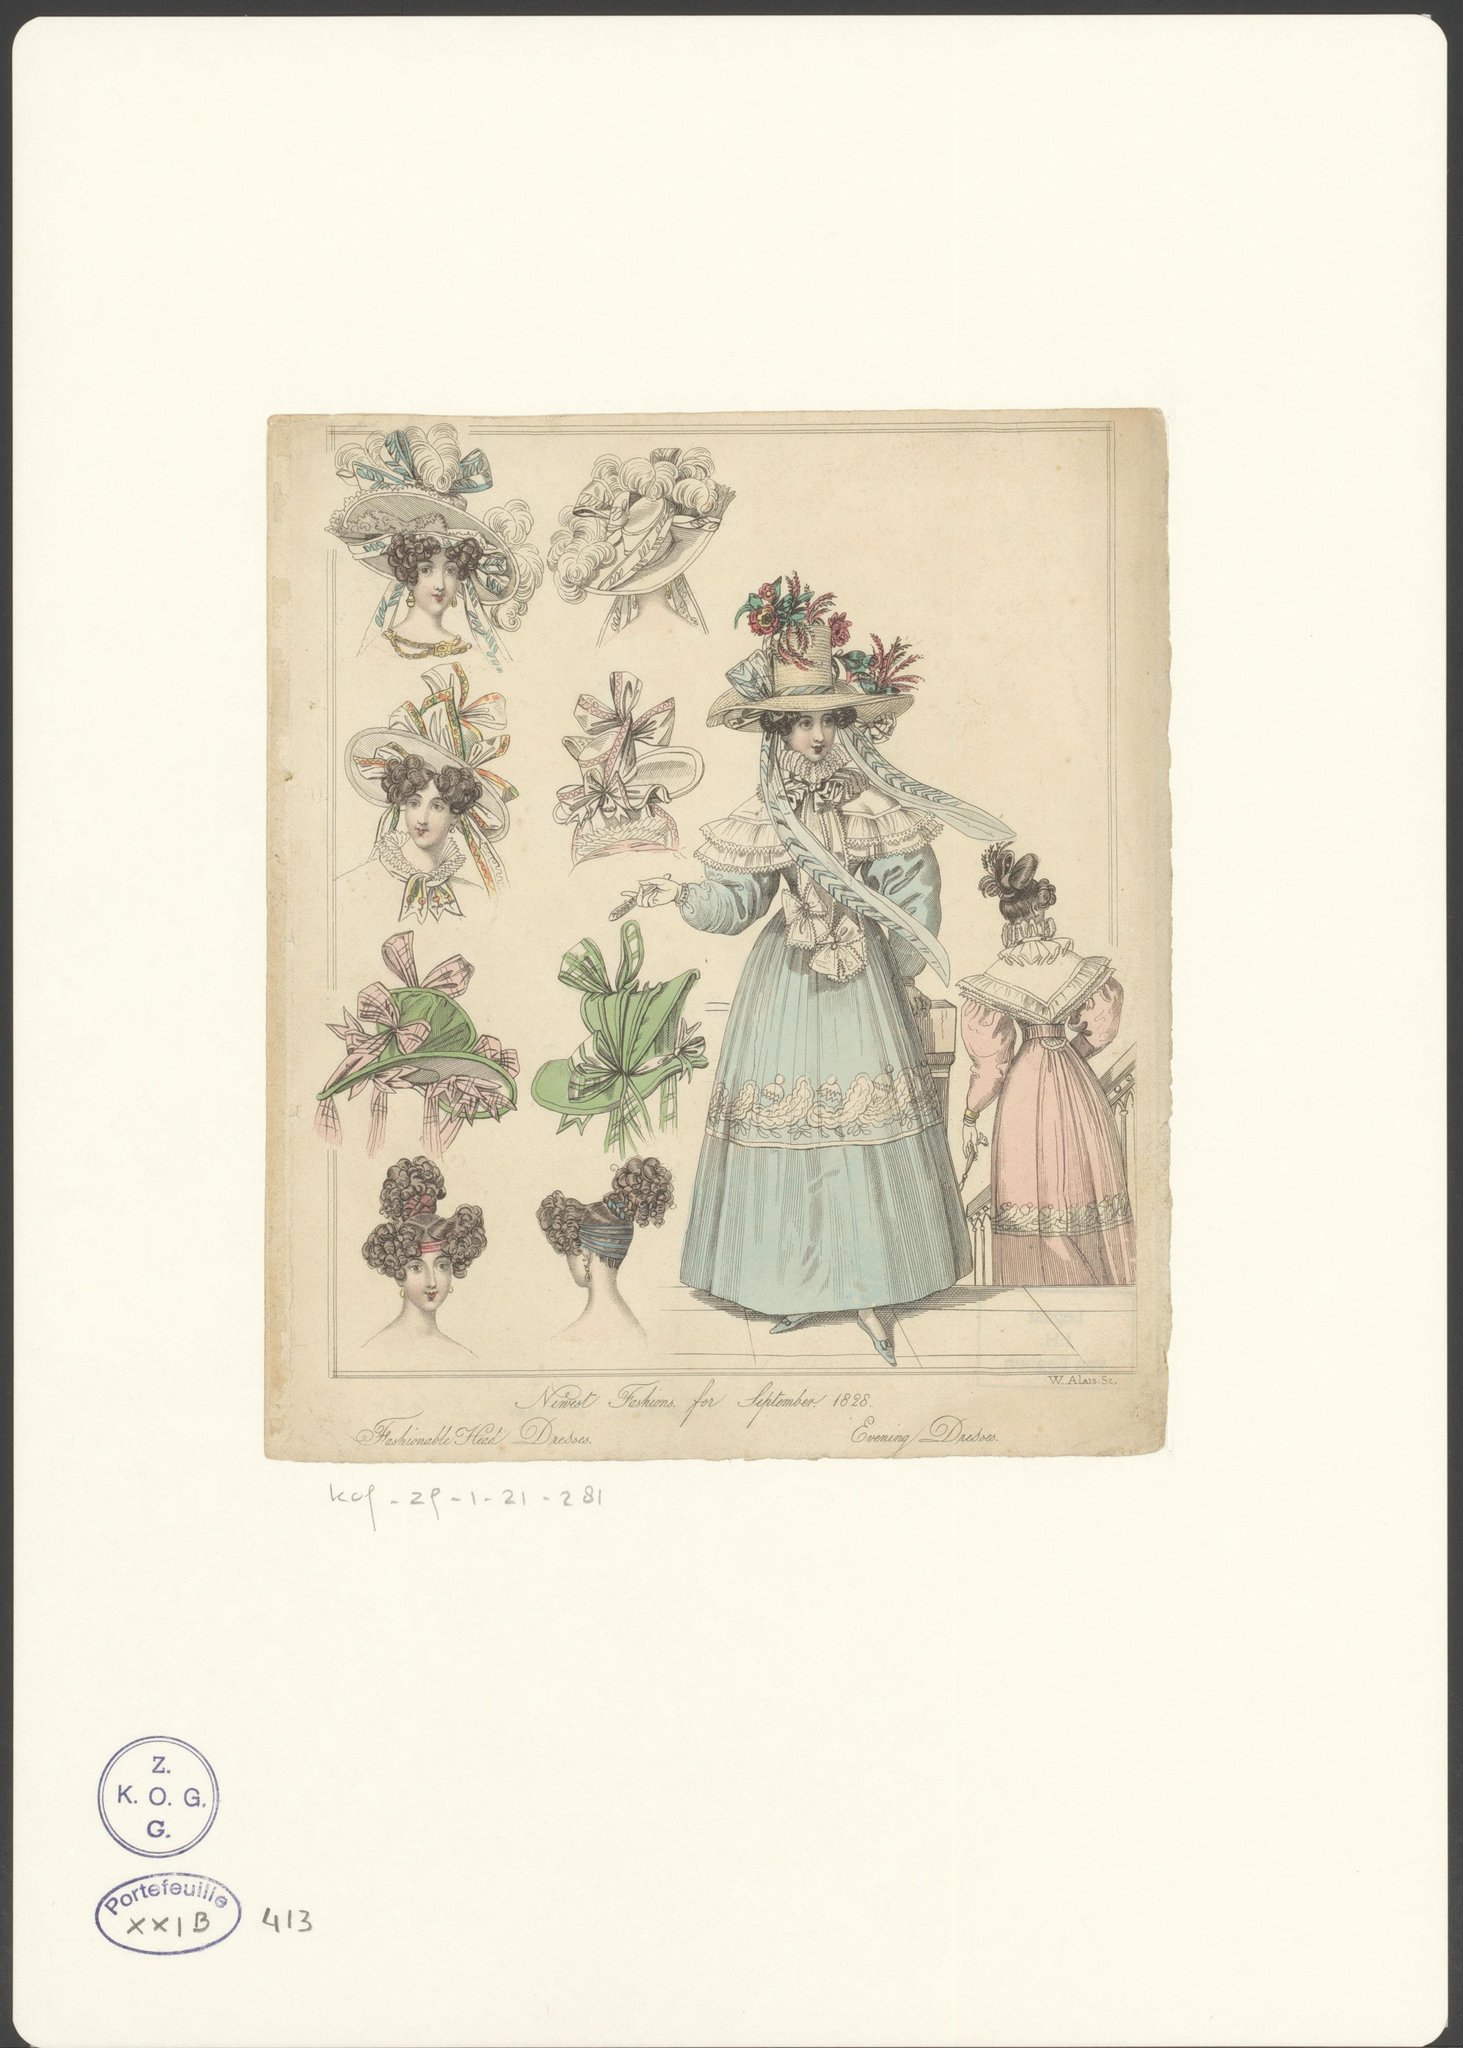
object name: print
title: Twee avondjurken en verschillende hoeden volgens de mode van september 1828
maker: william wolfe alais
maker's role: print maker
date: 1809-1828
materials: paper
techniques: etching, hand coloring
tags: fashion, clothing, styles of hairdress, head-gear: hat, dress, gown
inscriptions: stamp, stamp: ‘Legaat I.H. van Eeghen’, collector's mark: Lugt 1641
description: Onderwerpsrubrieken binnen de Atlas Zeden en Gewoonten: Zeden en Gewoonten in Engeren Zin, De Kleeding, Kleederdrachten (tijdvakken), De regeering van Willem I. Mannen en vrouwen.